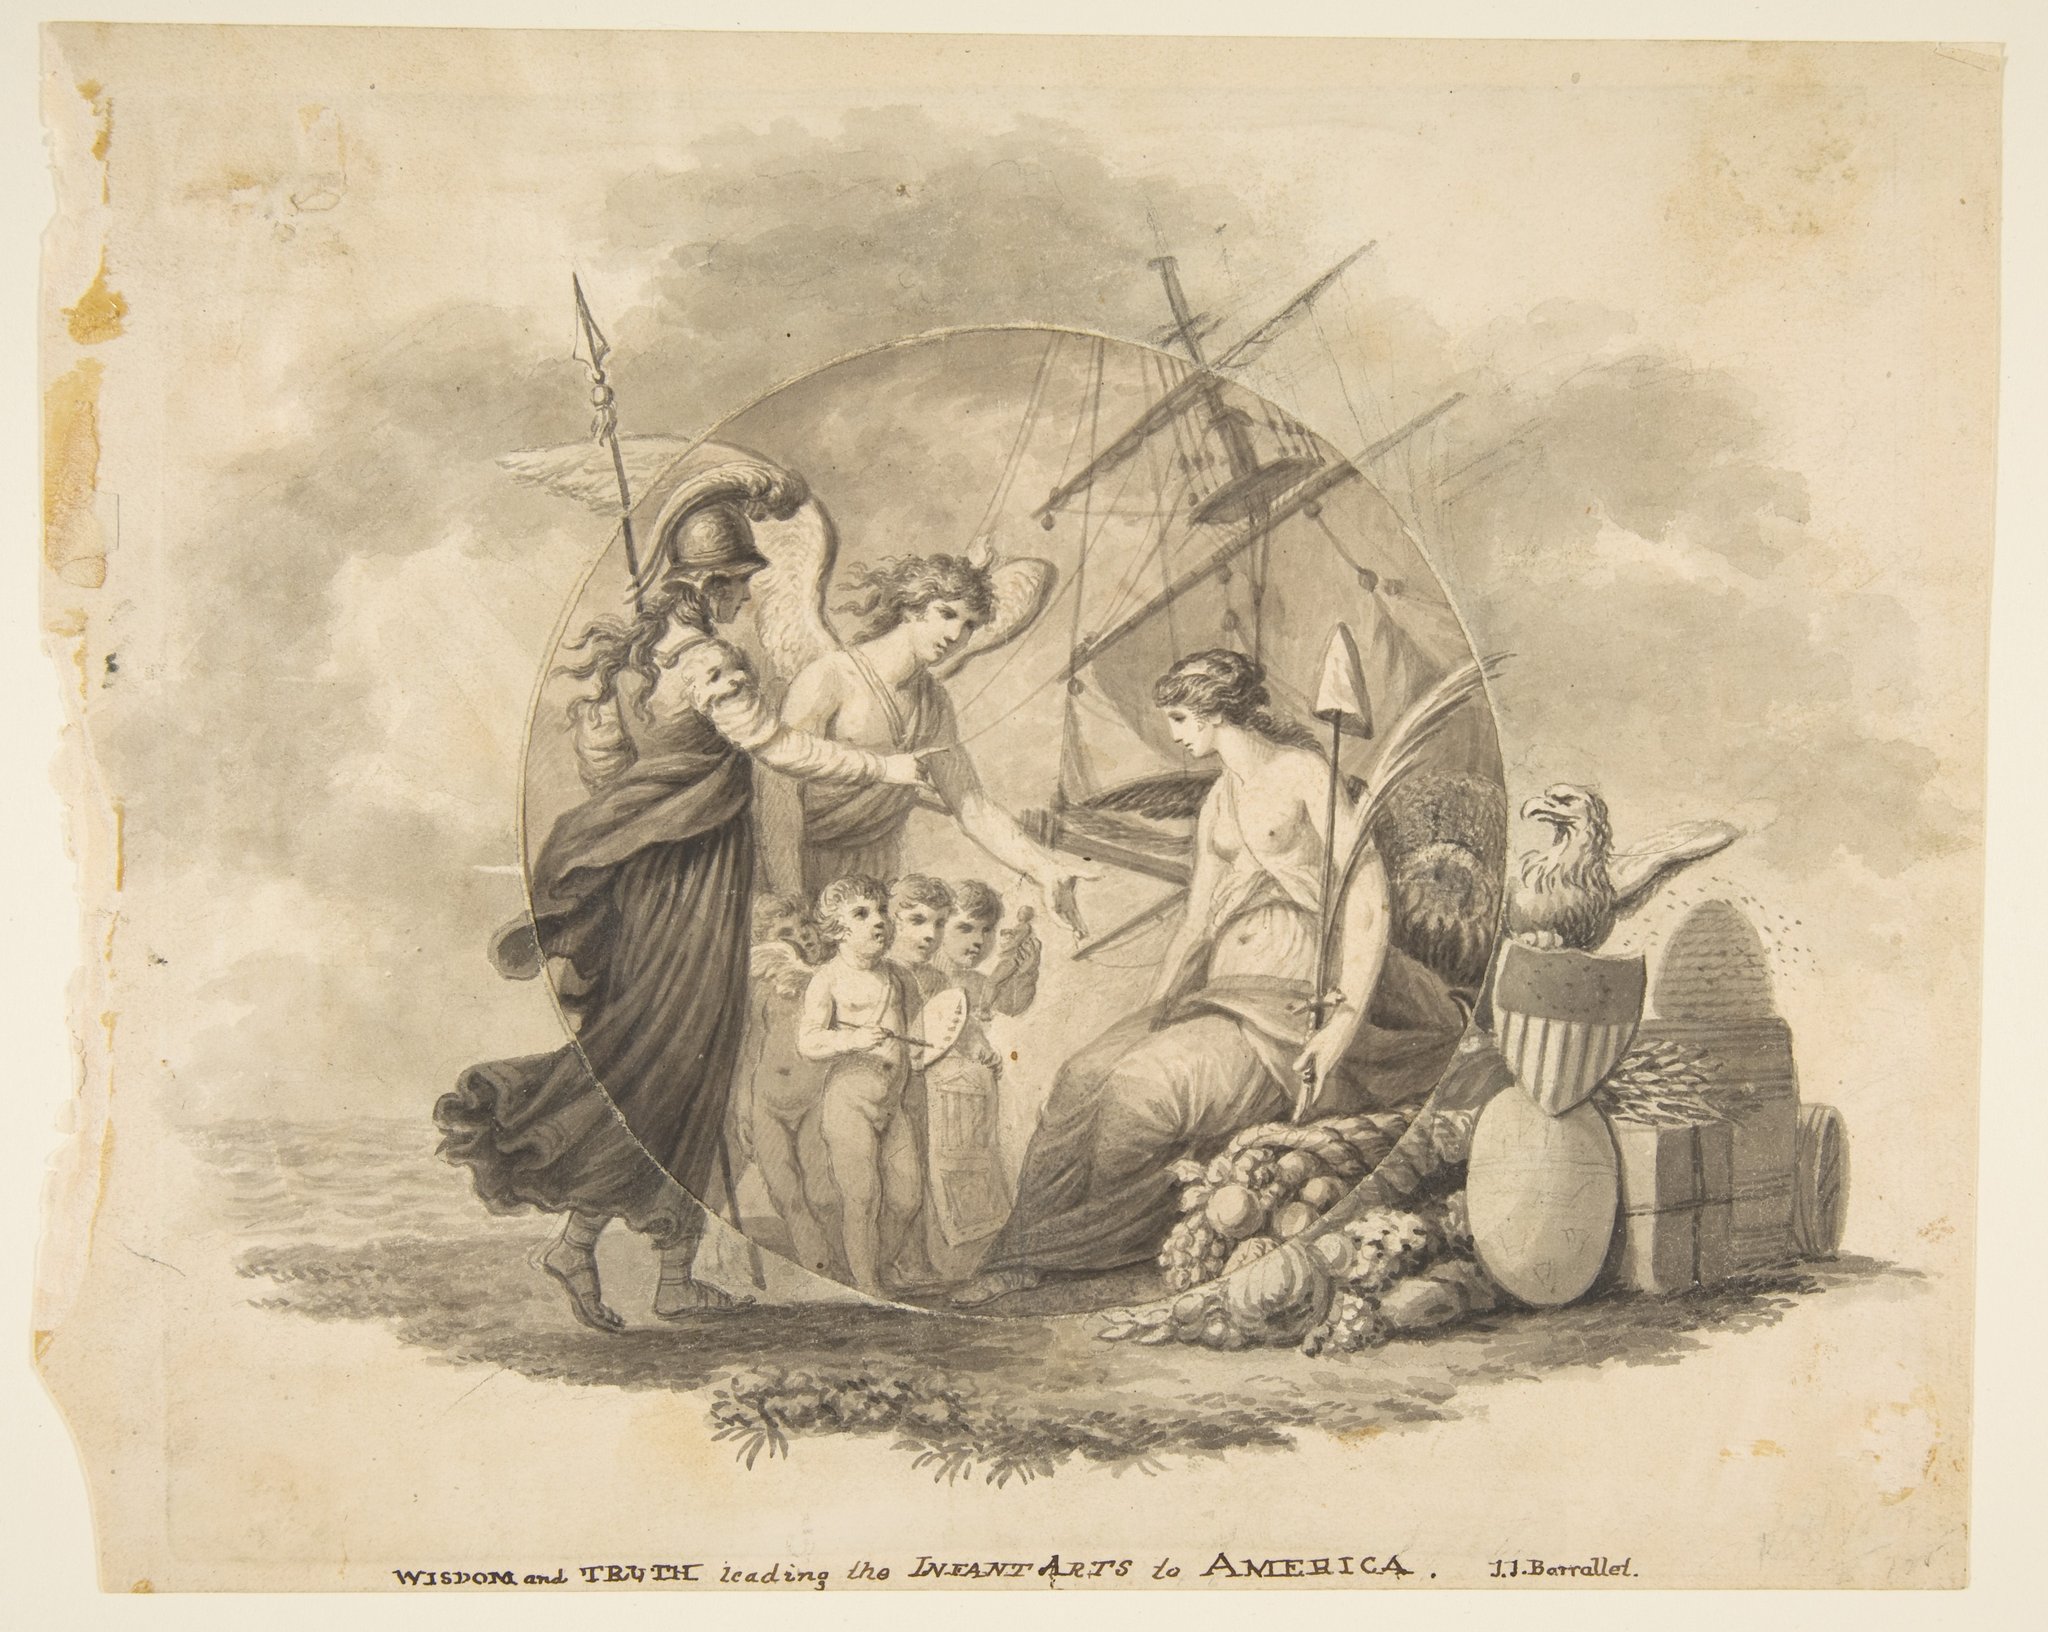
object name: drawing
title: Allegories of Wisdom and Truth Leading the Infant Arts to America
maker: john james barralet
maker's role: artist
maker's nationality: irish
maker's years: 1747-1815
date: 1796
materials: ink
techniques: brush, pen, wash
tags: food,birds,spears,women